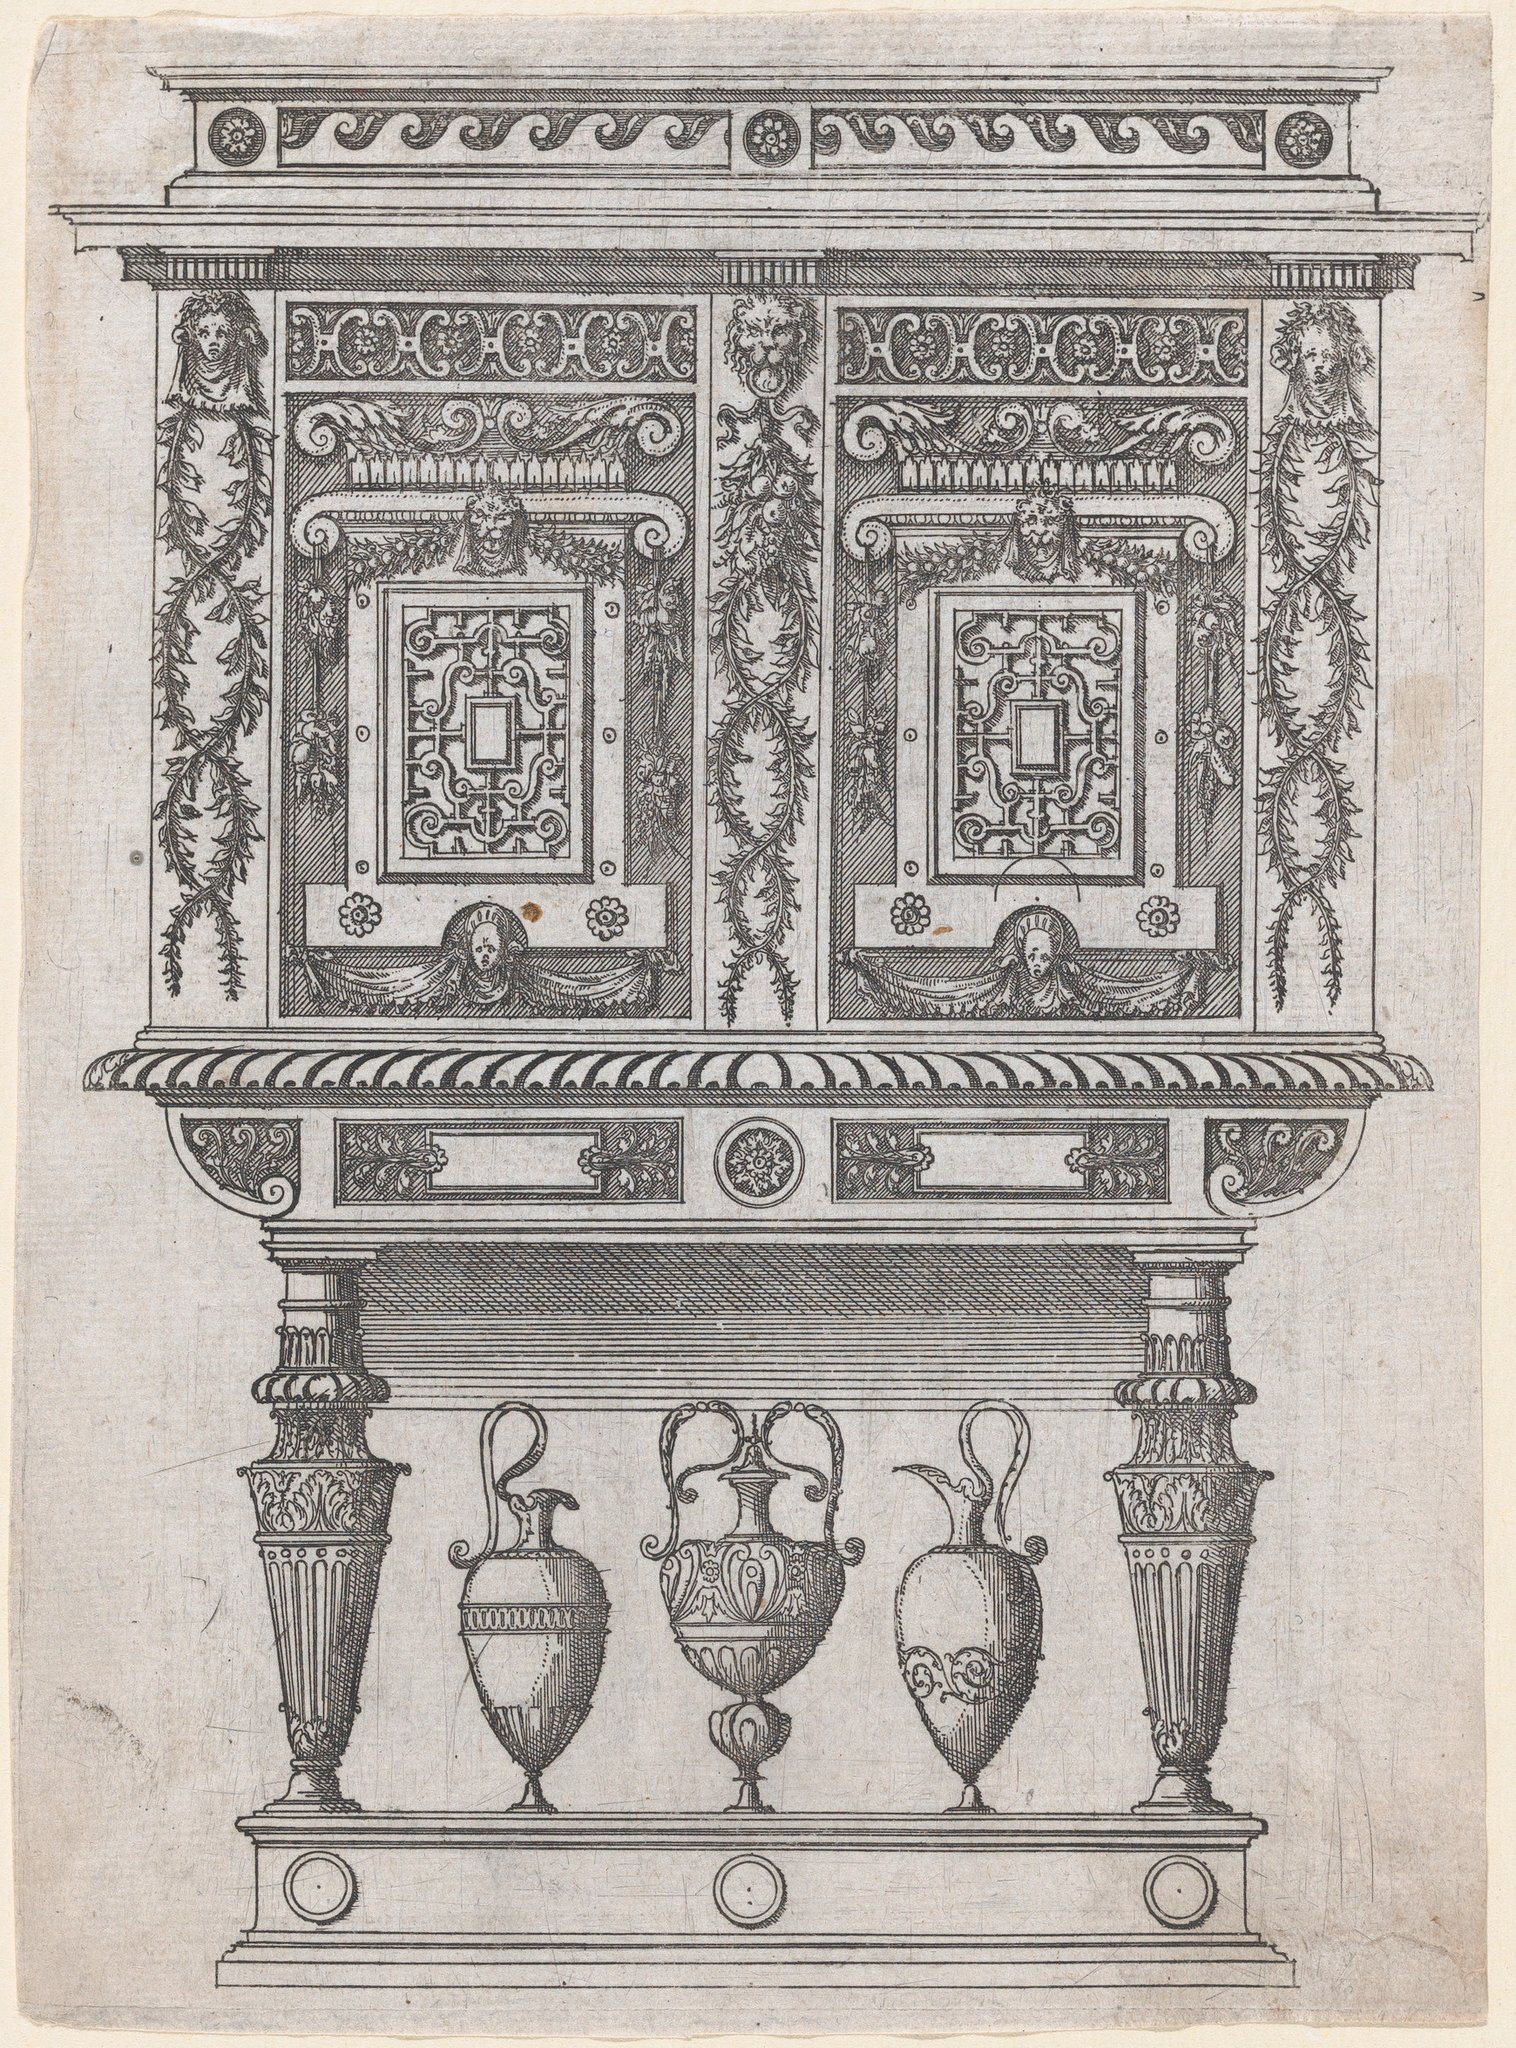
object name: print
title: Furniture Design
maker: jacques androuet du cerceau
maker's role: artist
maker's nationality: french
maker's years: 1510-1585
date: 1565-1570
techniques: etching